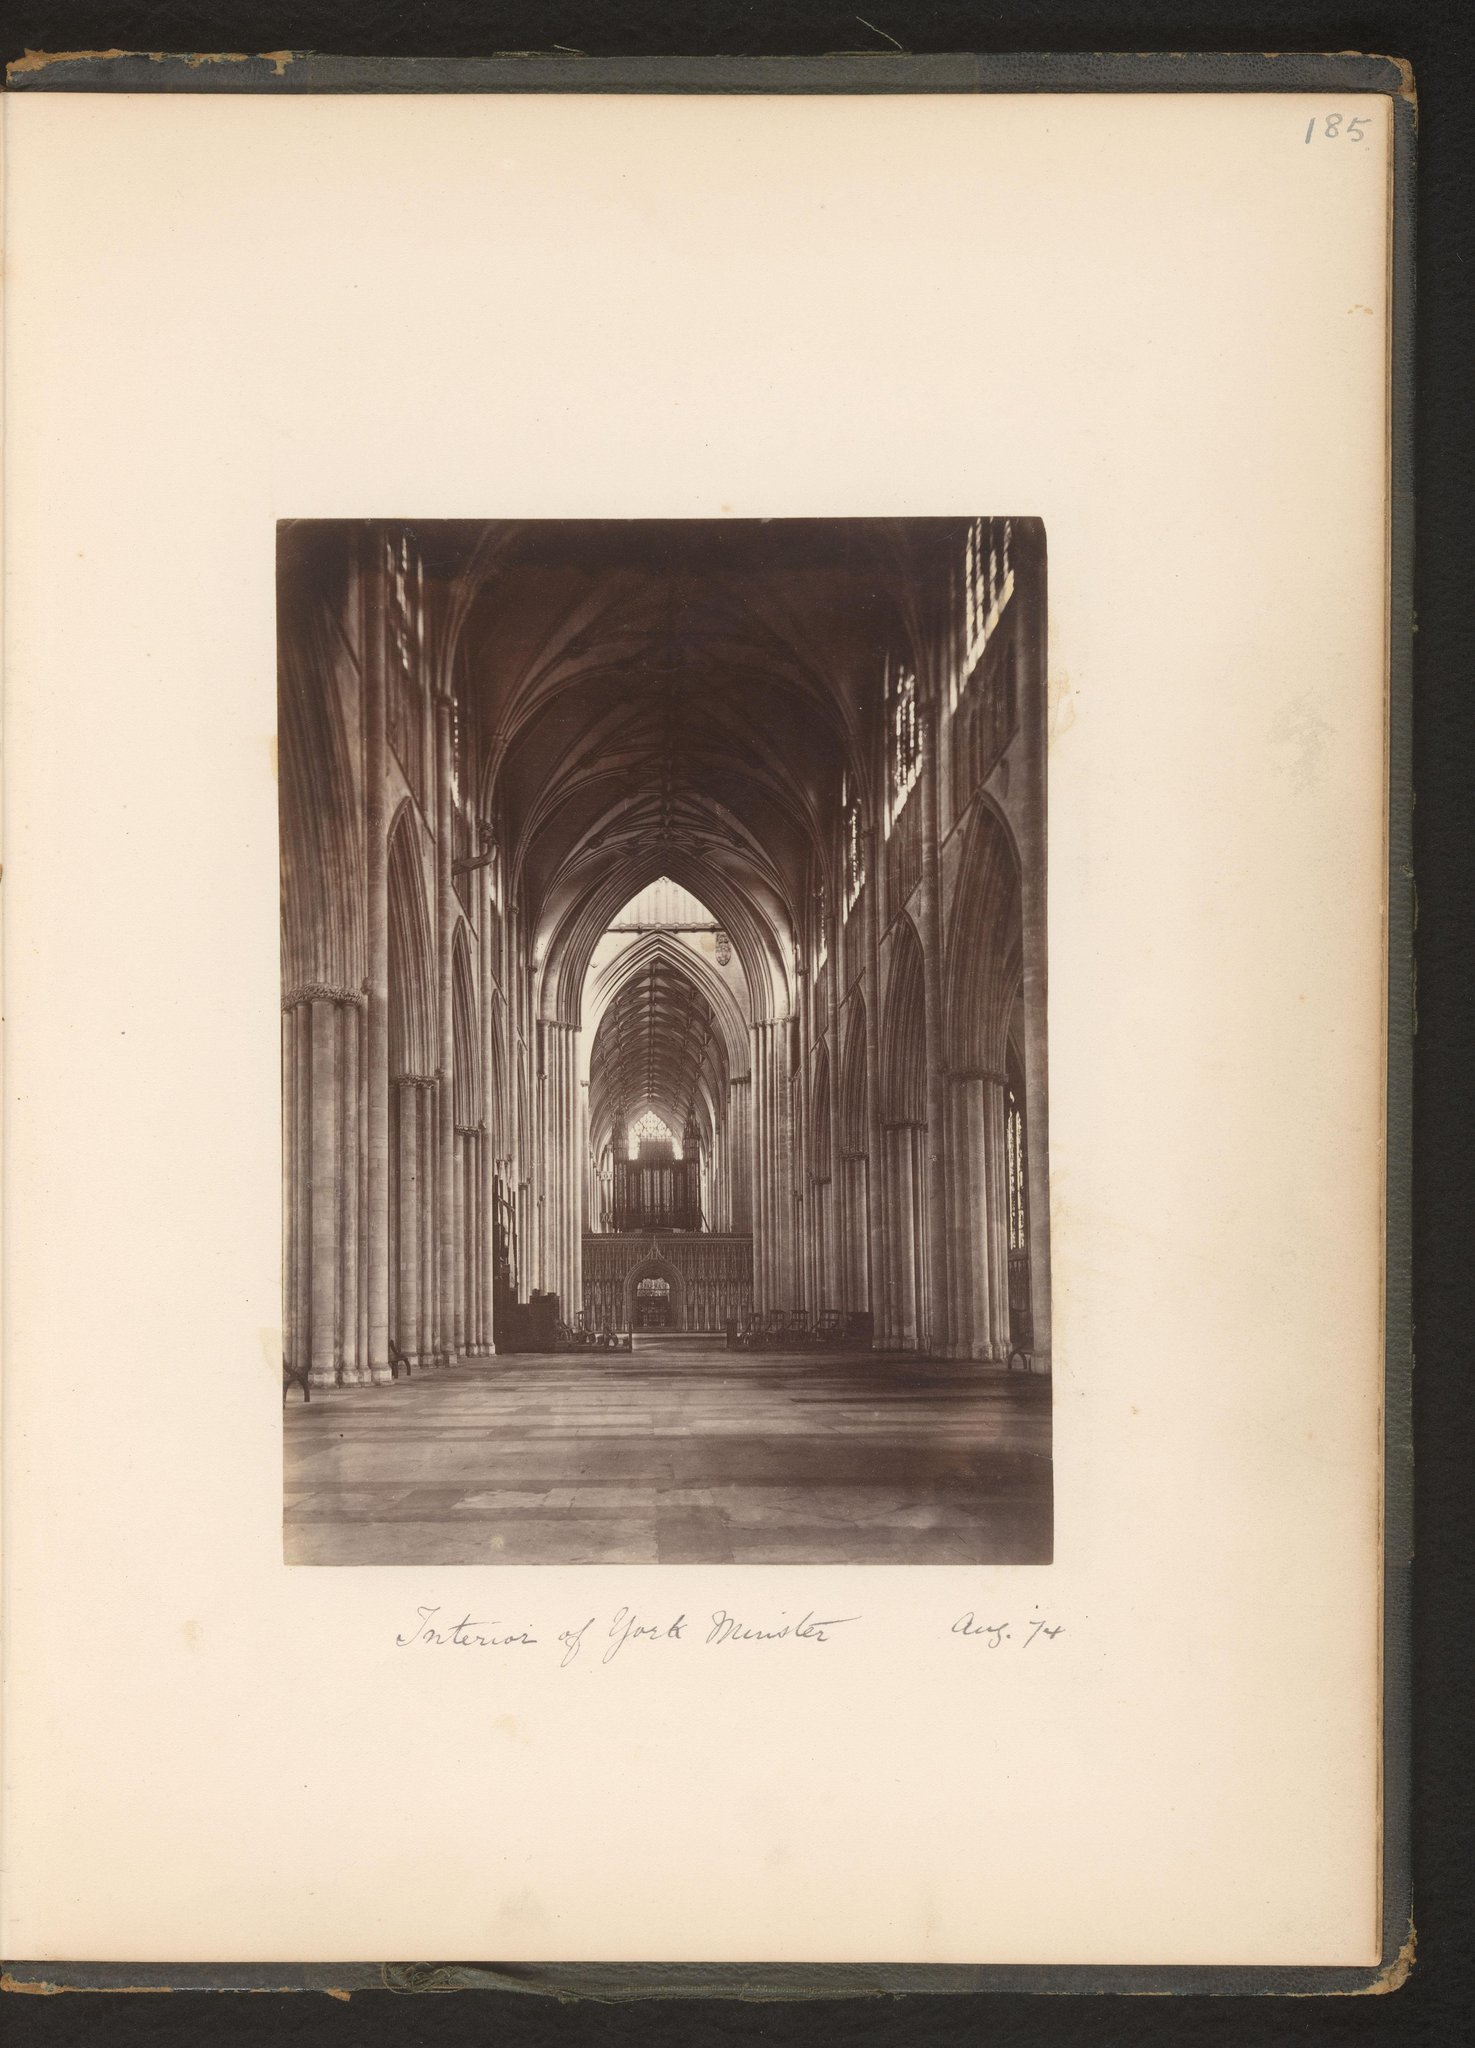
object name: album leaf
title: Interieur van York Minster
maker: Anonymous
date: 1808-1874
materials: paper, photographic support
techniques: albumen print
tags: interior of church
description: Deze pagina maakt deel uit van een album.